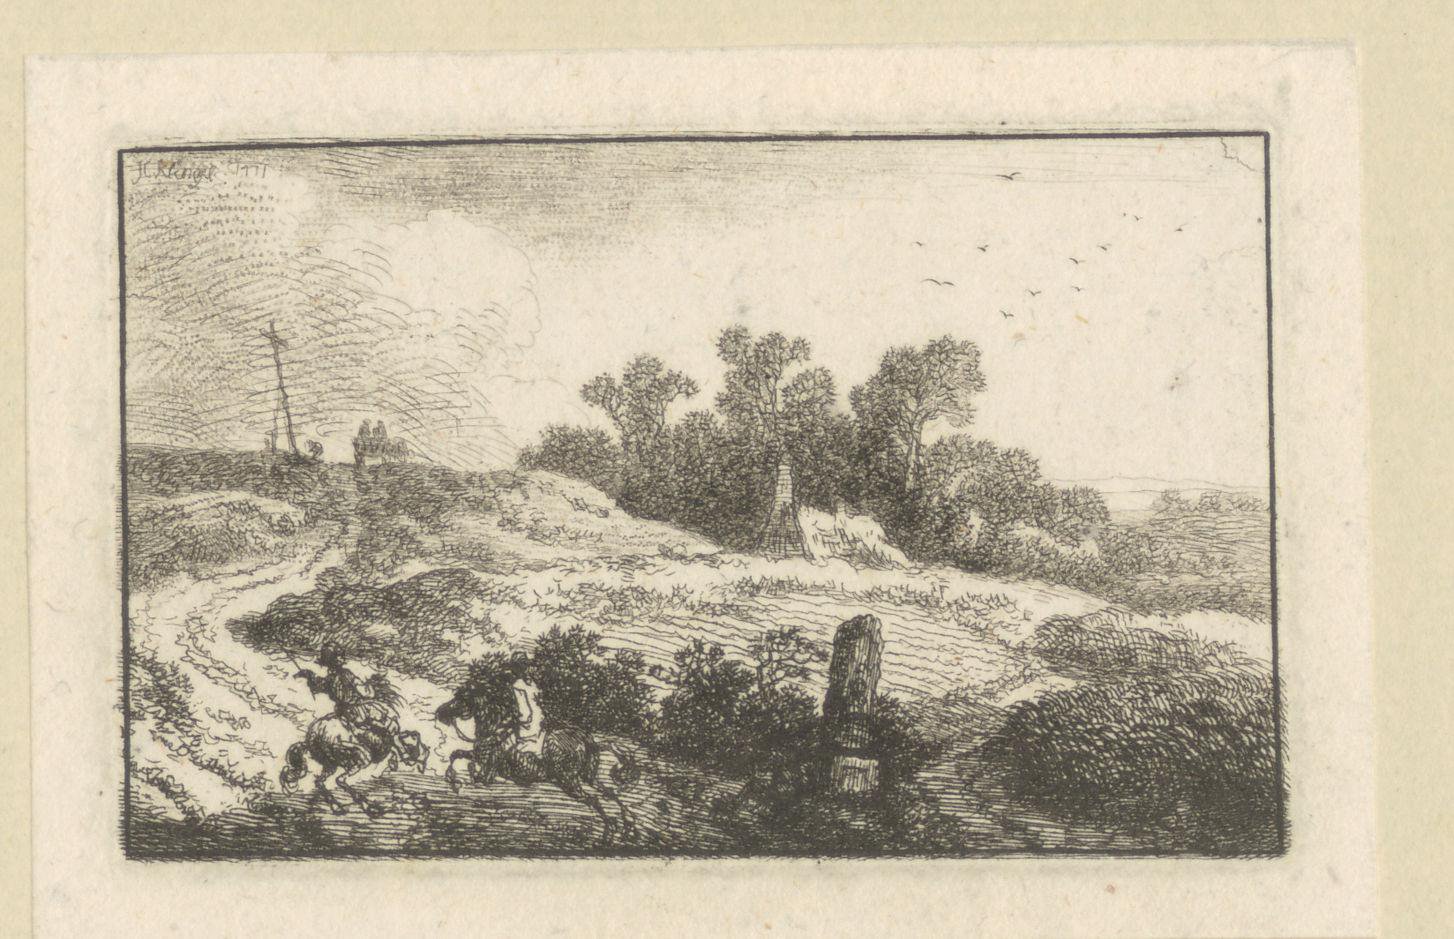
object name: print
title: Landschap met twee ruiters in galop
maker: johann christian klengel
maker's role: print maker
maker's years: 1751-1824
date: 1771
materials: paper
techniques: etching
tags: signpost, low hill country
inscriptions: collector's mark: Lugt 240